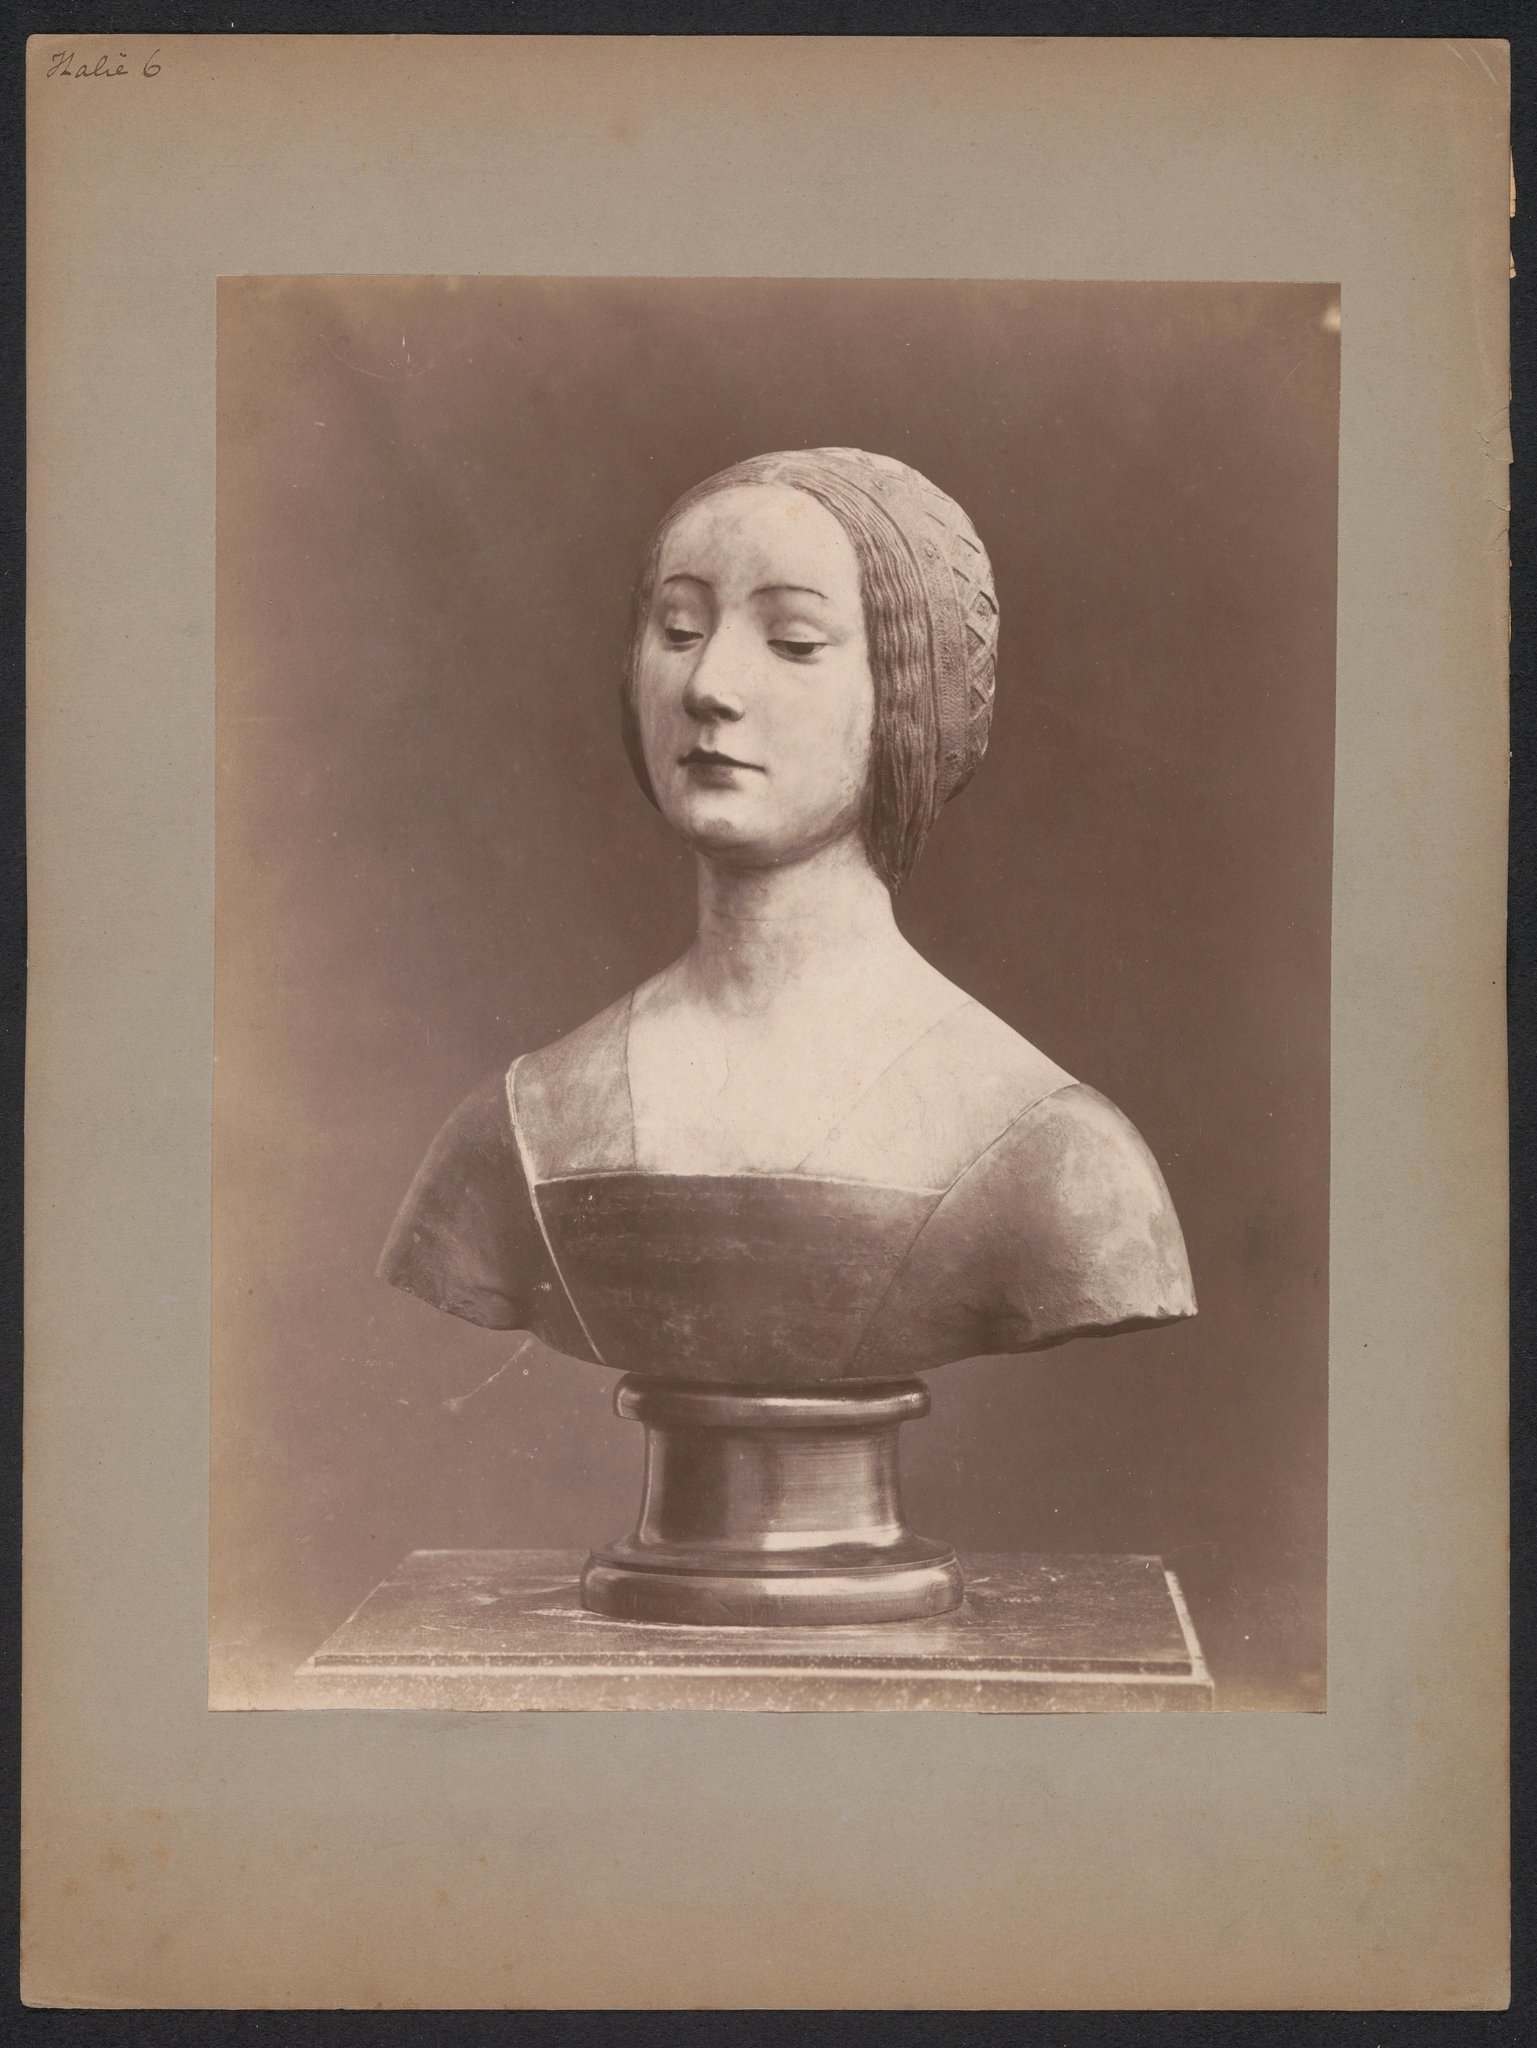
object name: photograph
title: Buste van een onbekende vrouw op een sokkel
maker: Anonymous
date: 1850-1900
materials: cardboard, photographic support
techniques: albumen print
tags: sculpture, anonymous historical person portrayed - bb - woman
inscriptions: annotation: ‘Beschilderde Marmeren/ buste’, collector's mark: ‘RIJKS NORMAALSCHOOL voor TEEKEN[ONDERWIJZERS] AMSTER[DAM]’, annotation: ‘Italië 6’